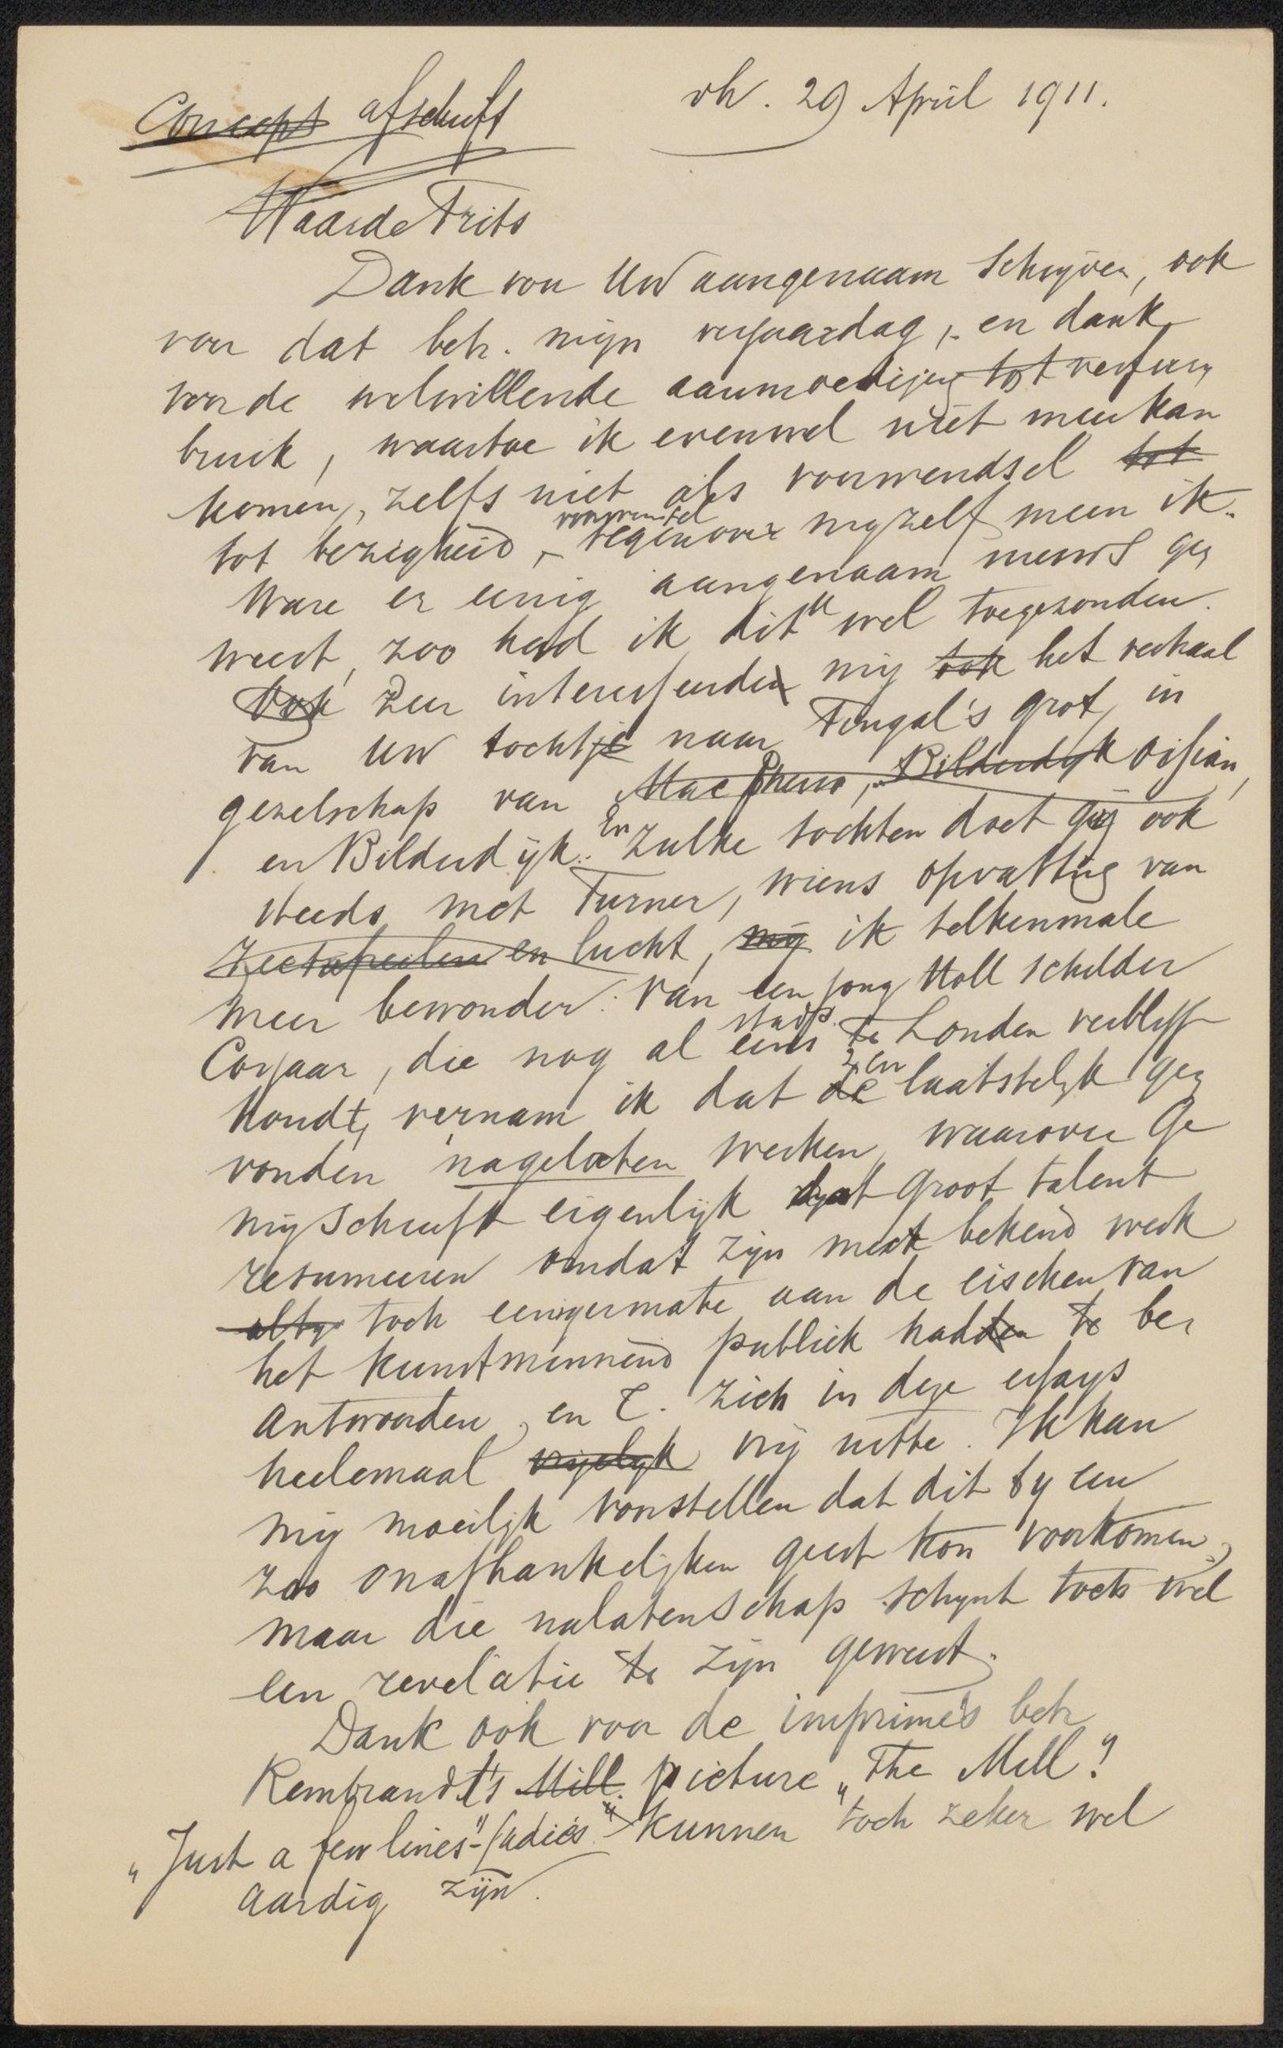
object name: letter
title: Brief aan onbekend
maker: august allebé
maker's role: draughtsman, print maker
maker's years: 1838-1927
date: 1911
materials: ink, paper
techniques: pen, writing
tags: travelling; tourism